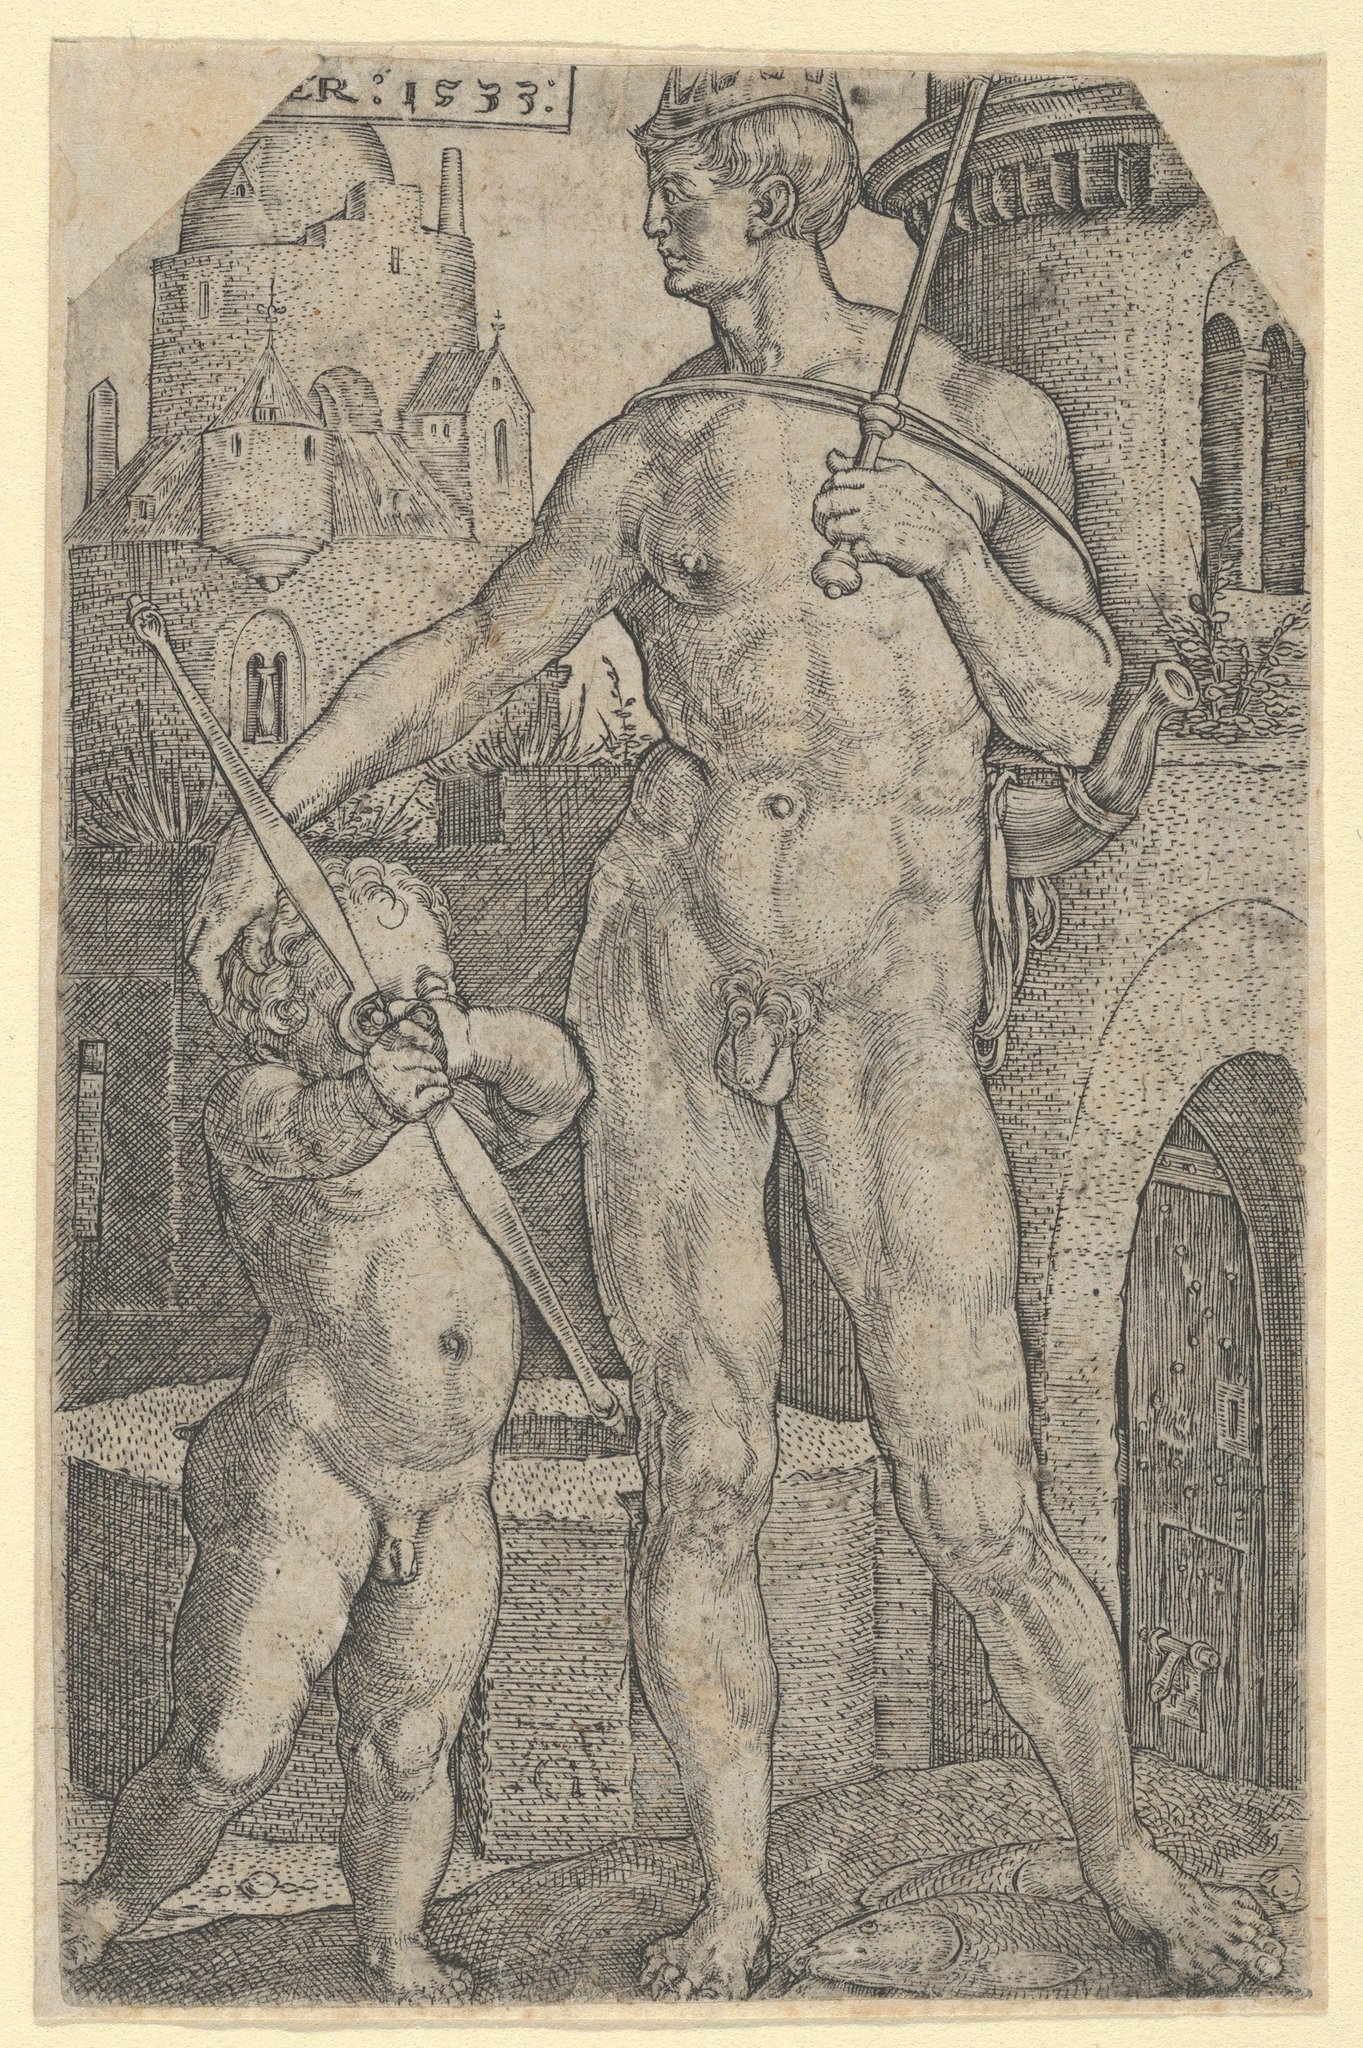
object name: print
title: Jupiter, from "The Seven Planets"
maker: heinrich aldegrever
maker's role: artist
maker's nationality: german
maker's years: 1502-1561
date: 1533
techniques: engraving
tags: bow and arrow,jupiter